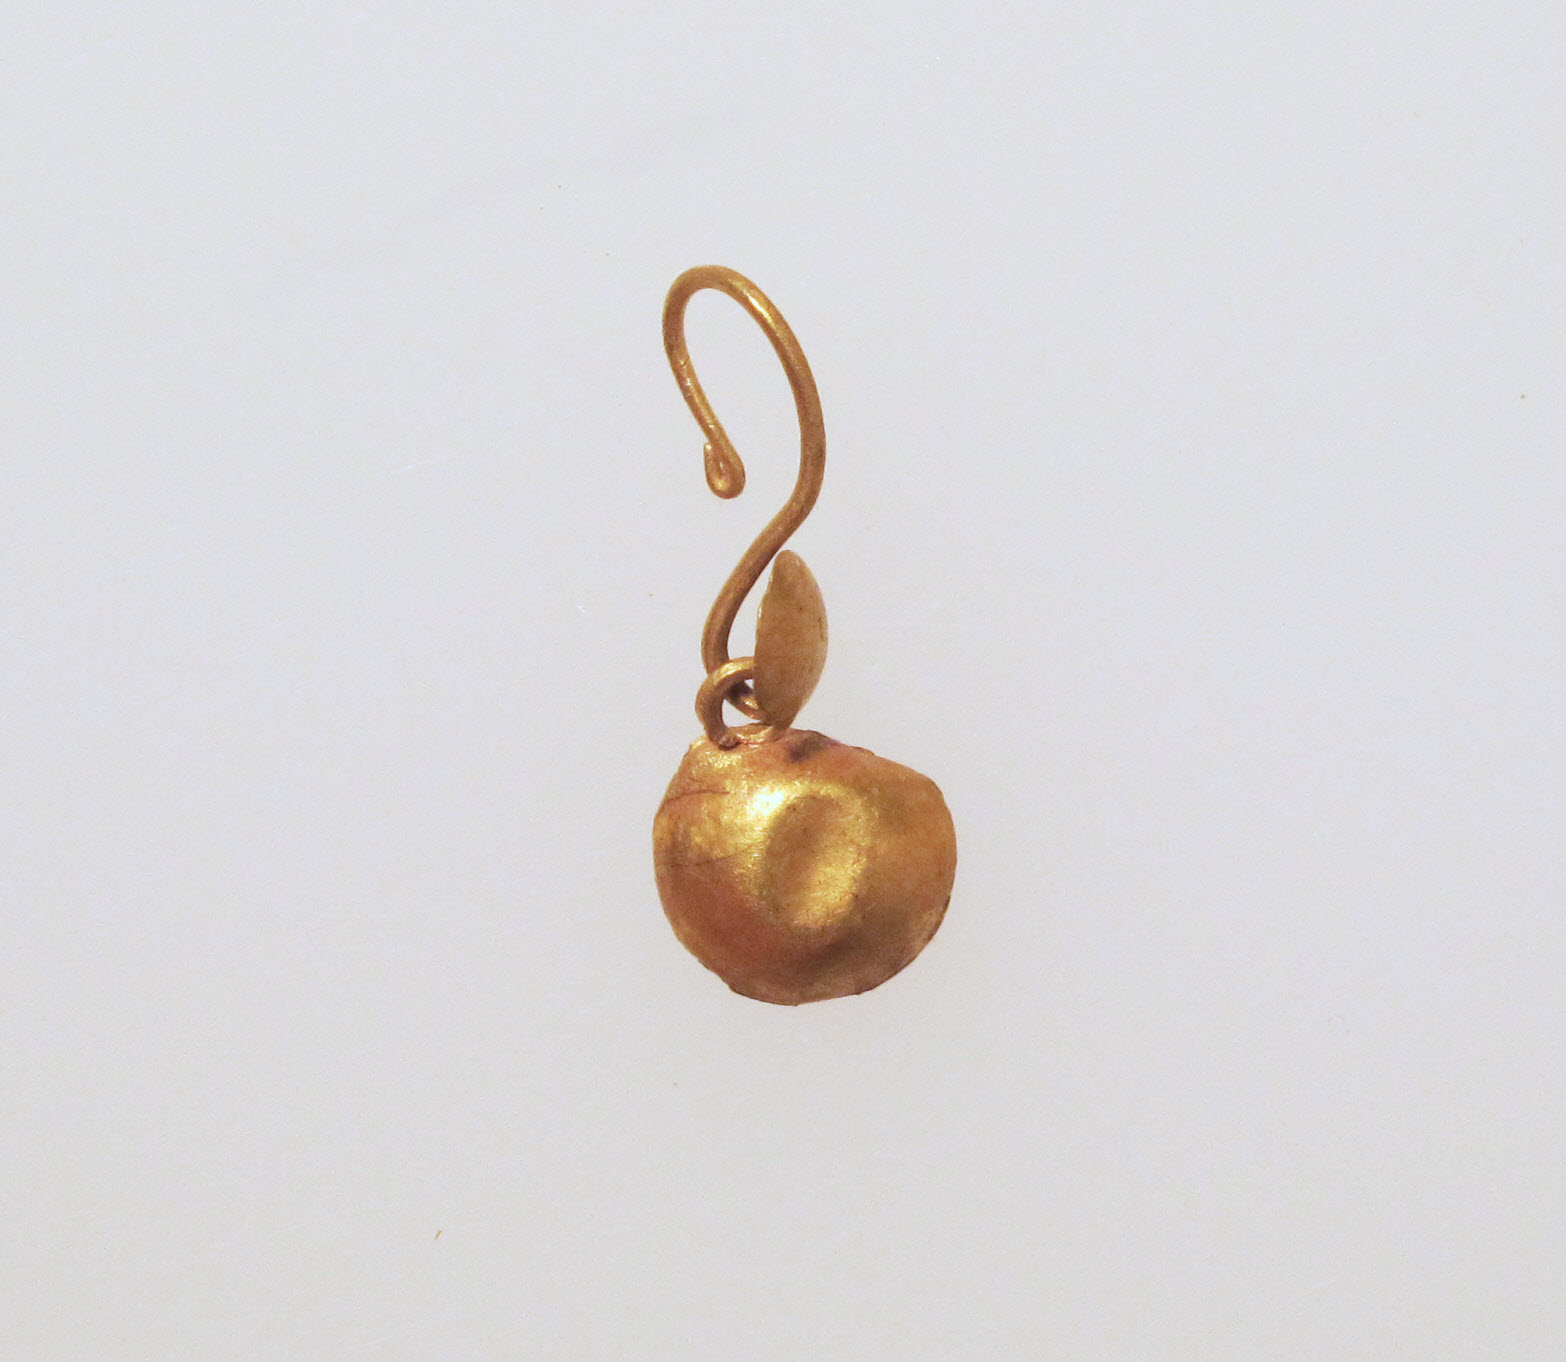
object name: earring with plain loop and disc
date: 7000 BCE-330 CE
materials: gold